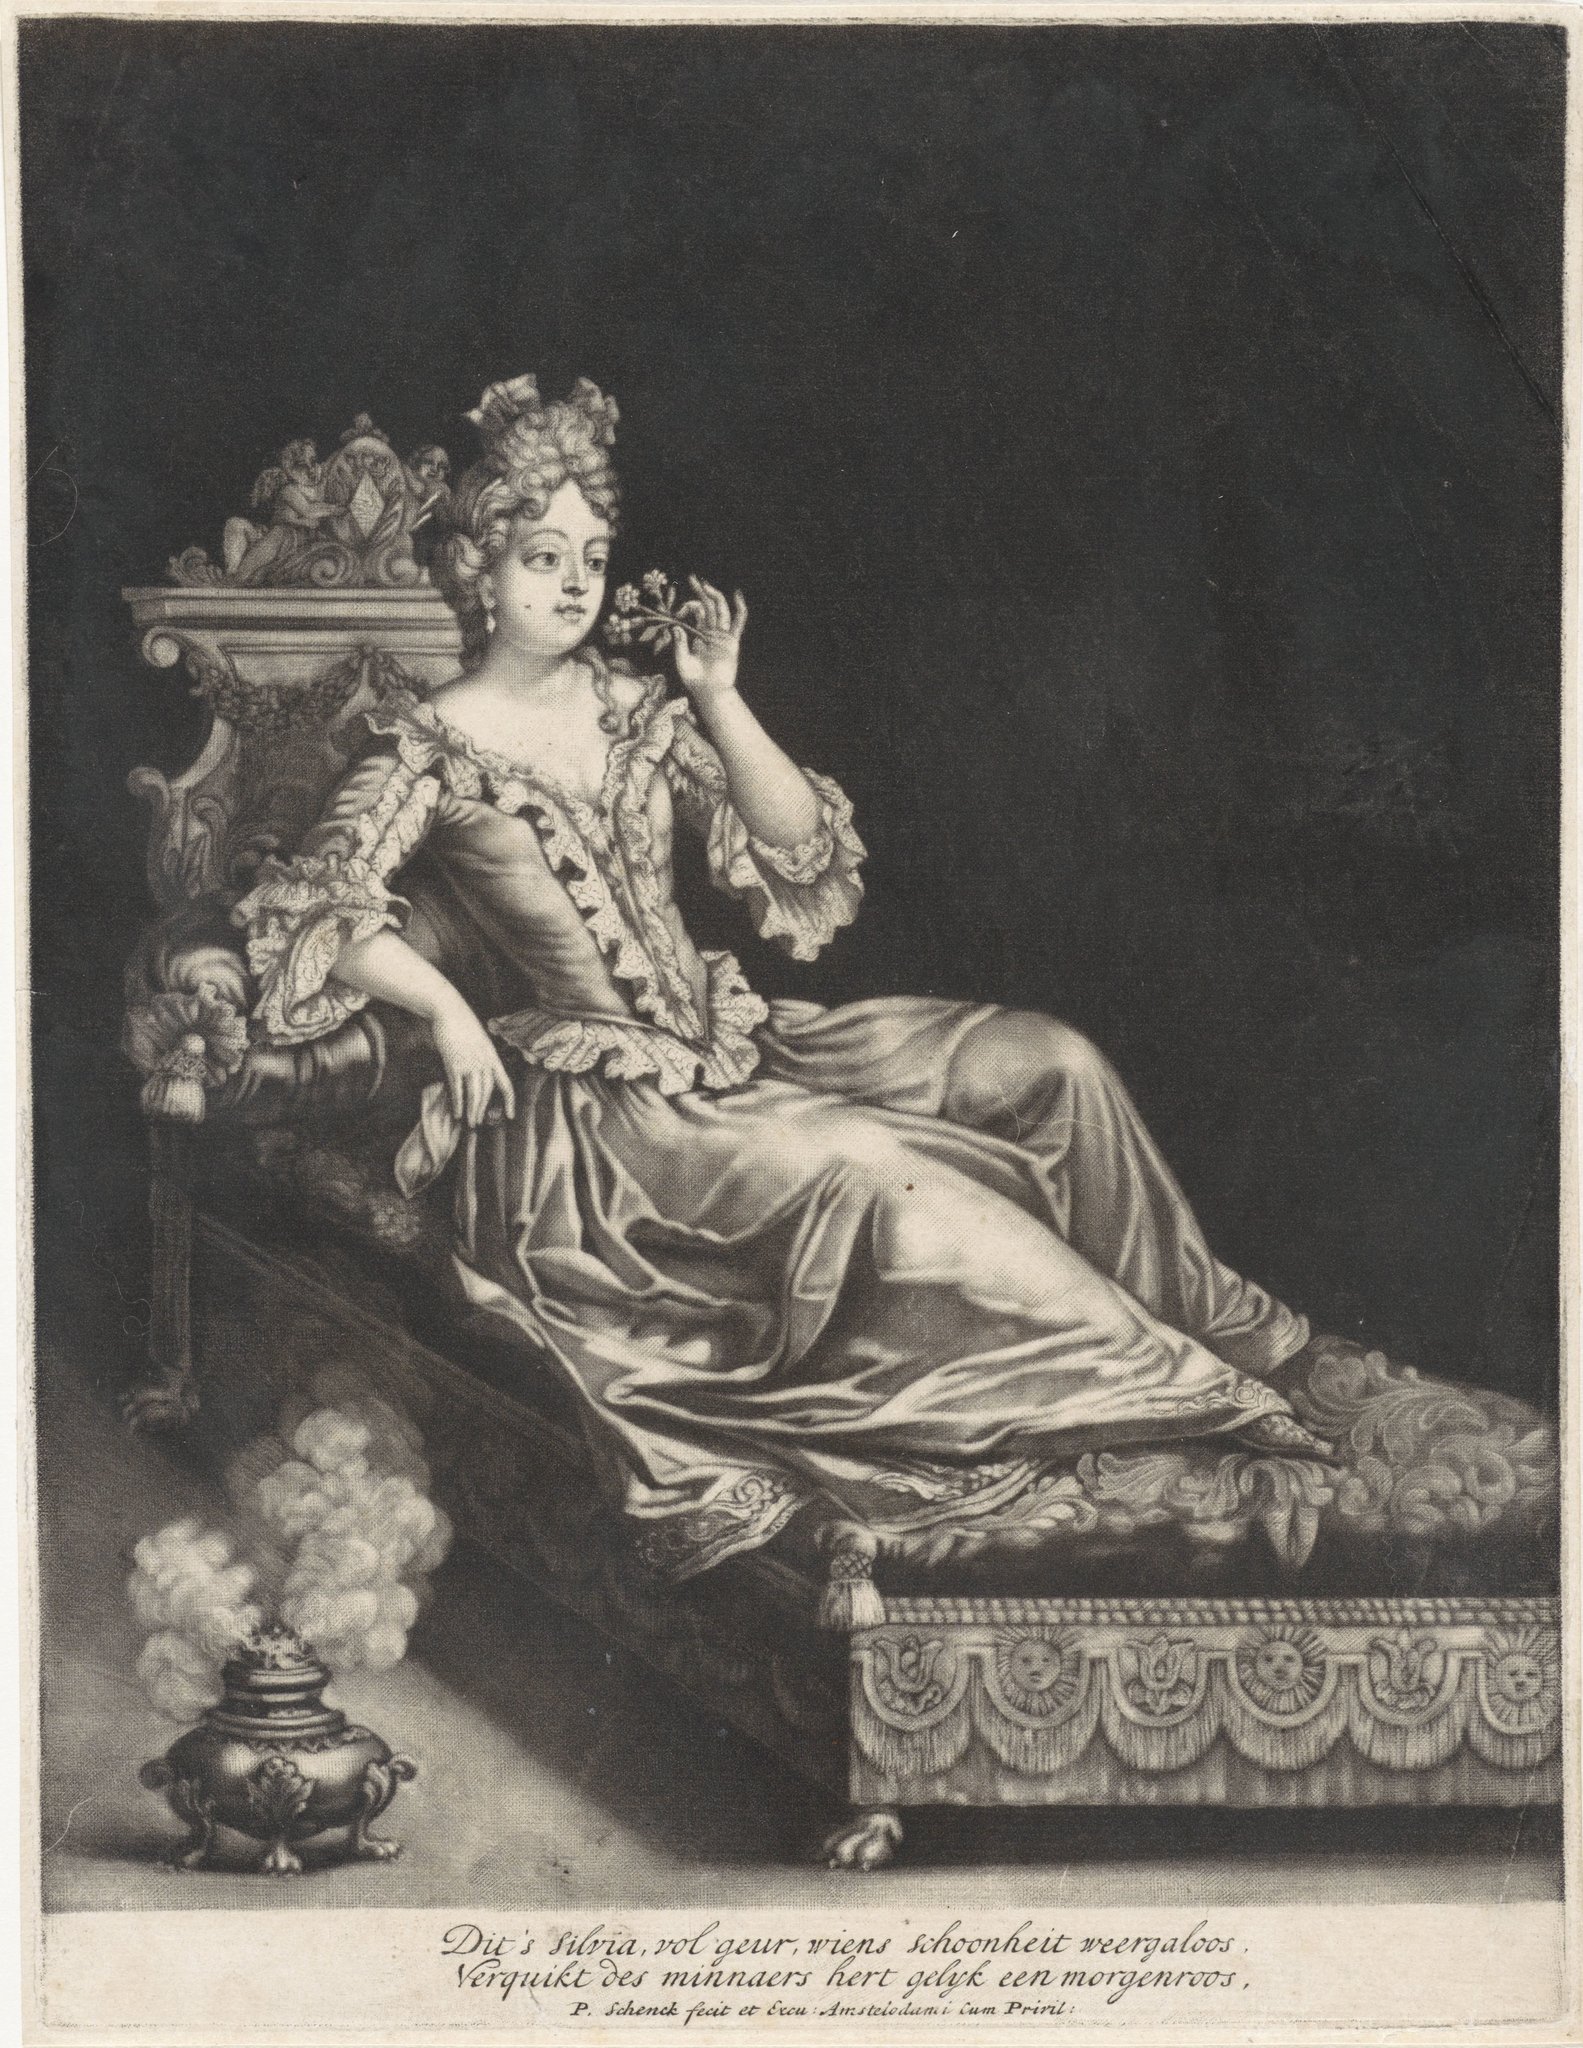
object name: print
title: Jonge vrouw op een bed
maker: pieter schenk (i)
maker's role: print maker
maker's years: 1660-1711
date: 1670-1713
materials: paper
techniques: mezzotint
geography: amsterdam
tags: cut flowers; nosegay, bunch of flowers, smell, smelling (one of the five senses), bed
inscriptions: collector's mark: Lugt 2228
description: Een elegant geklede vrouw ligt op een bed en ruikt aan een bloem. Naast het bed staat een walmend wierookvat.